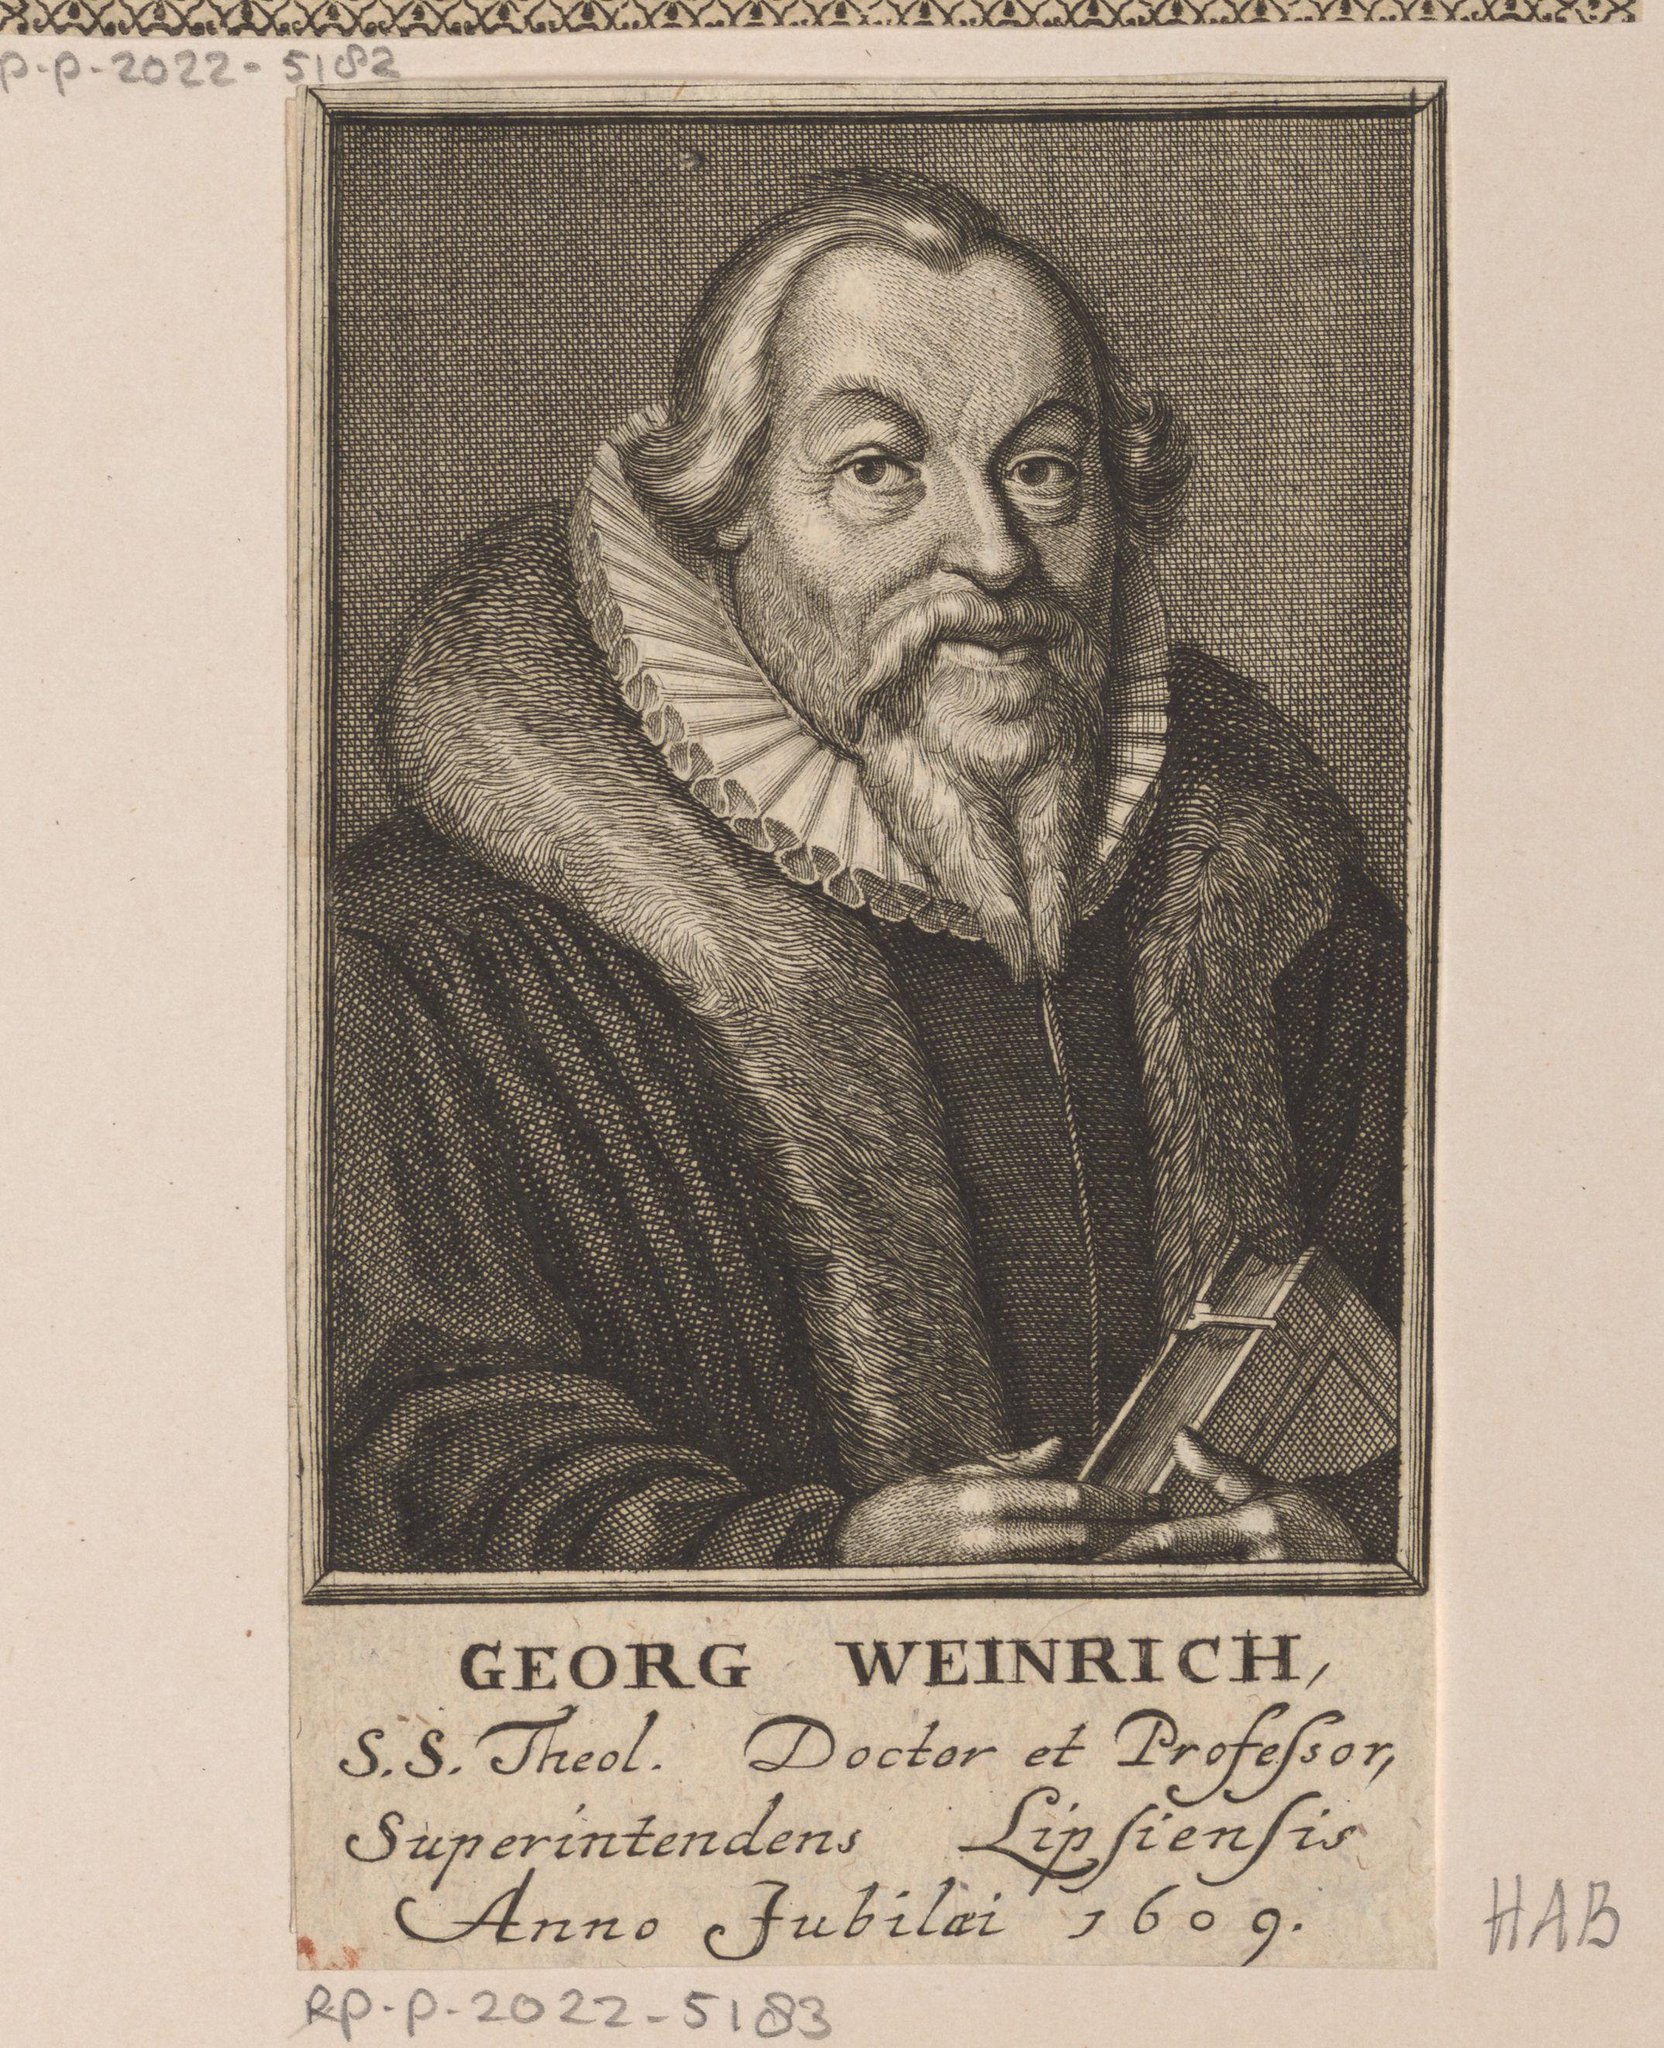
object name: print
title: Portret van Georg Weinrich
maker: johann georg mentzel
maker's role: print maker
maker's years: 1677-1743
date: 1687-1743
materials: paper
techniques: engraving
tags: theologian, historical persons, book, professor